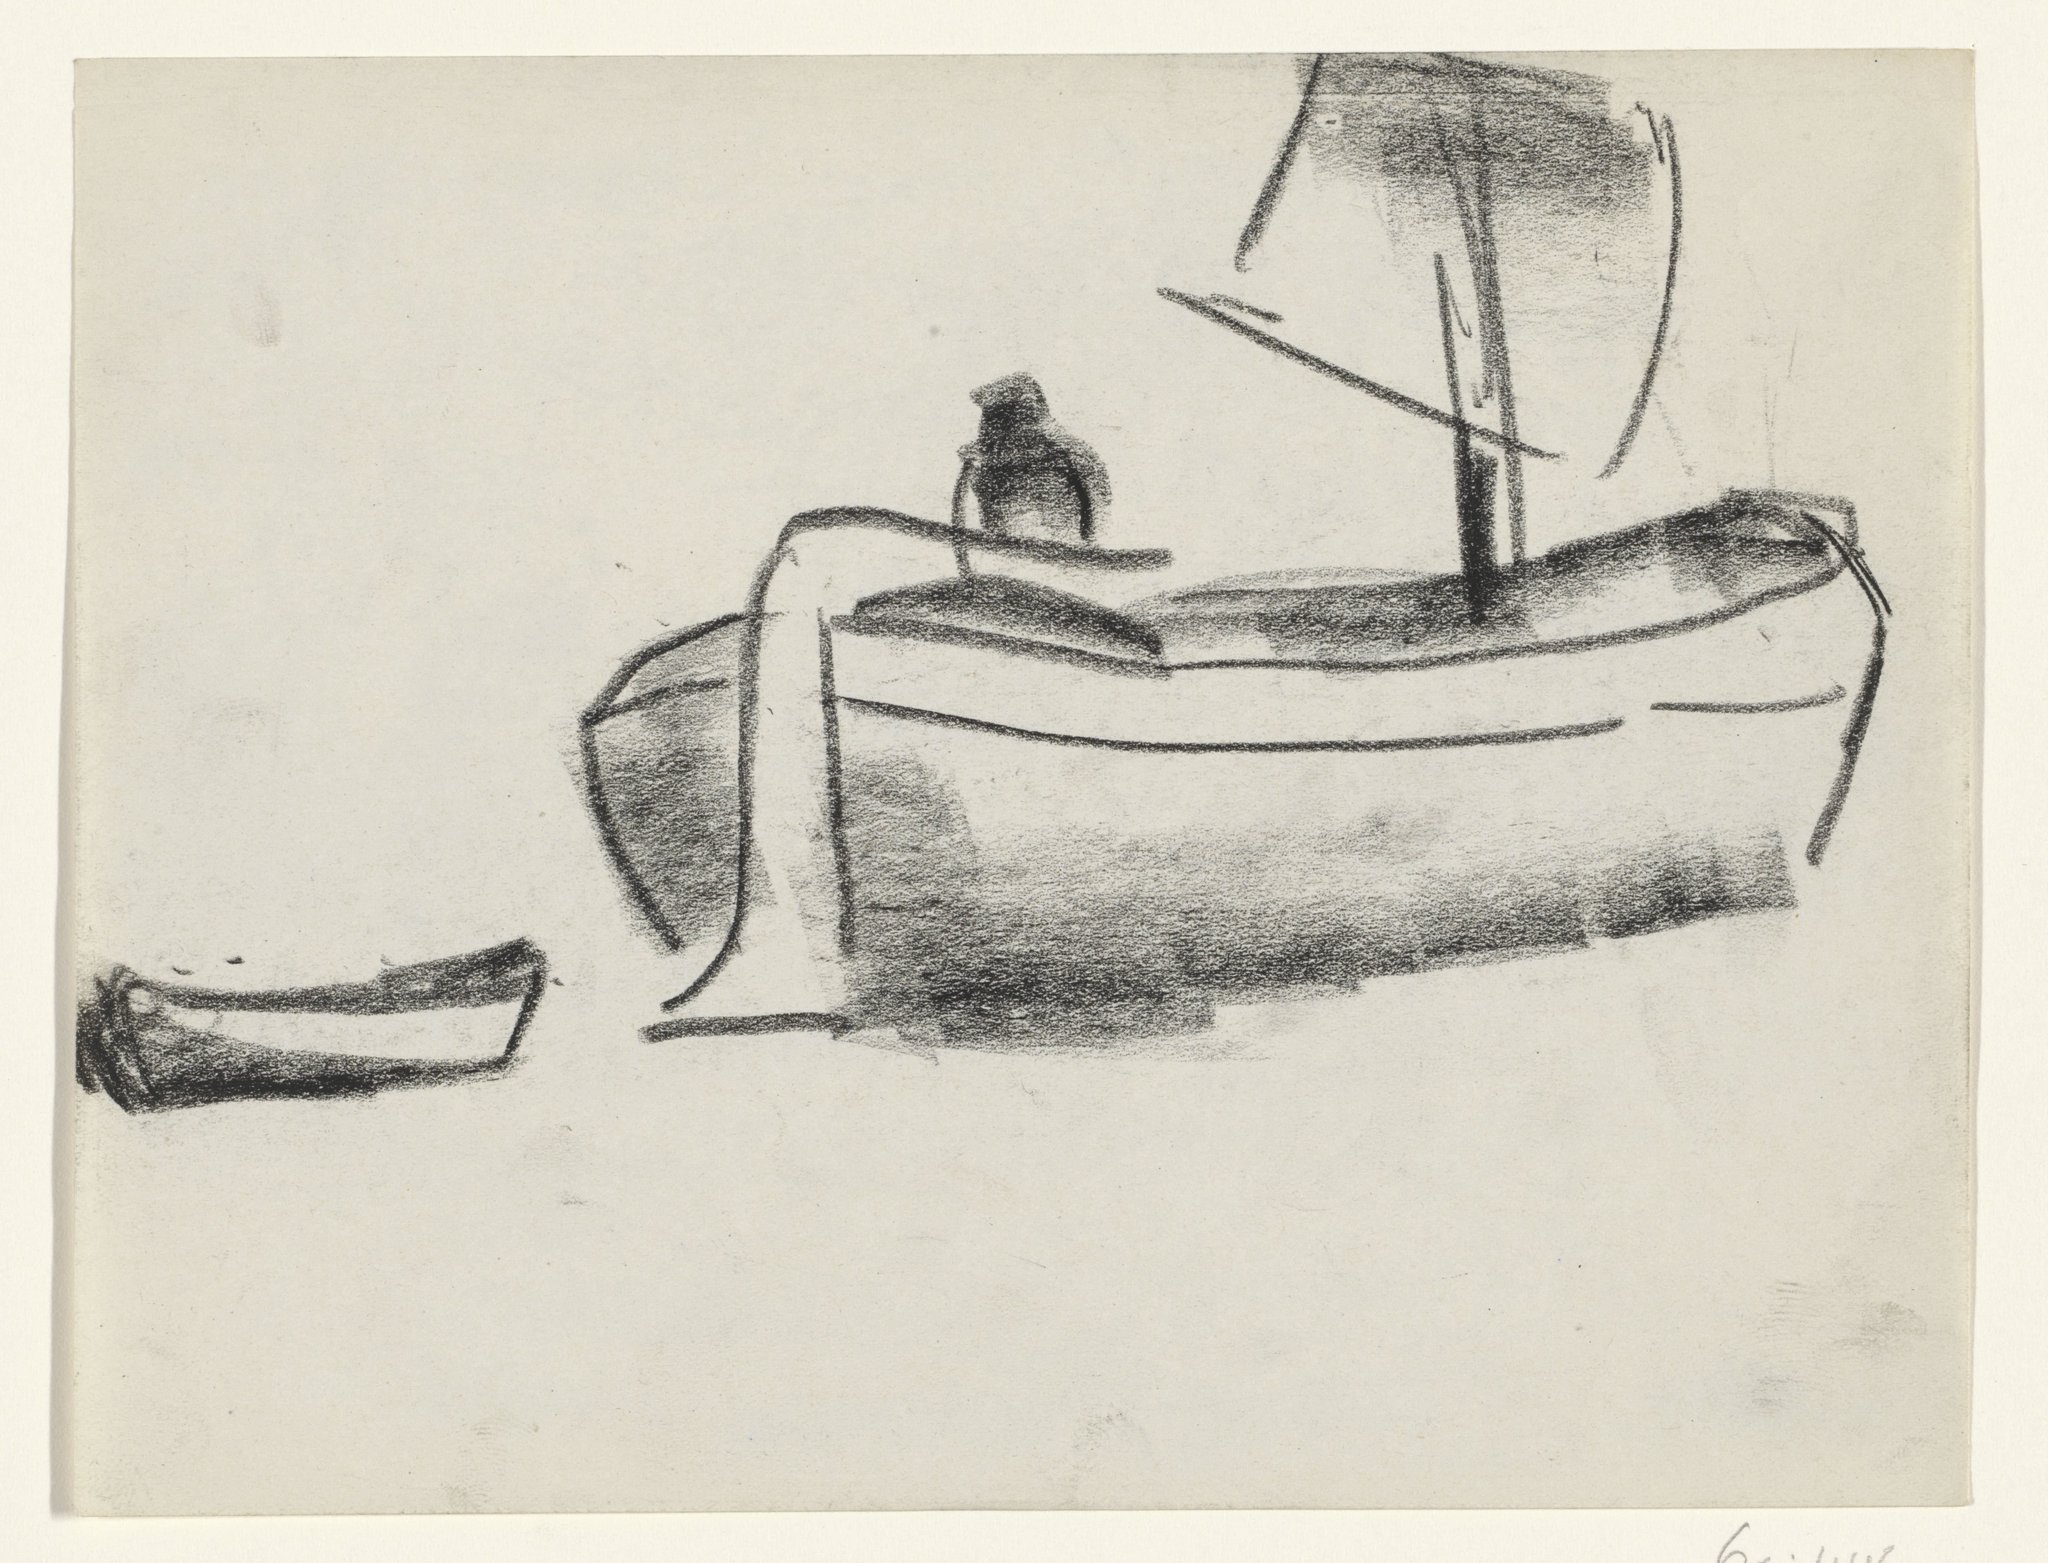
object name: drawing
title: Zeilschip met een man aan het roer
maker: leo gestel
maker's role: draughtsman, print maker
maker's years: 1881-1941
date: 1891-1941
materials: chalk, paper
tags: sailing-ship, sailing-boat, male sex; man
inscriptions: collector's mark: Lugt 2228